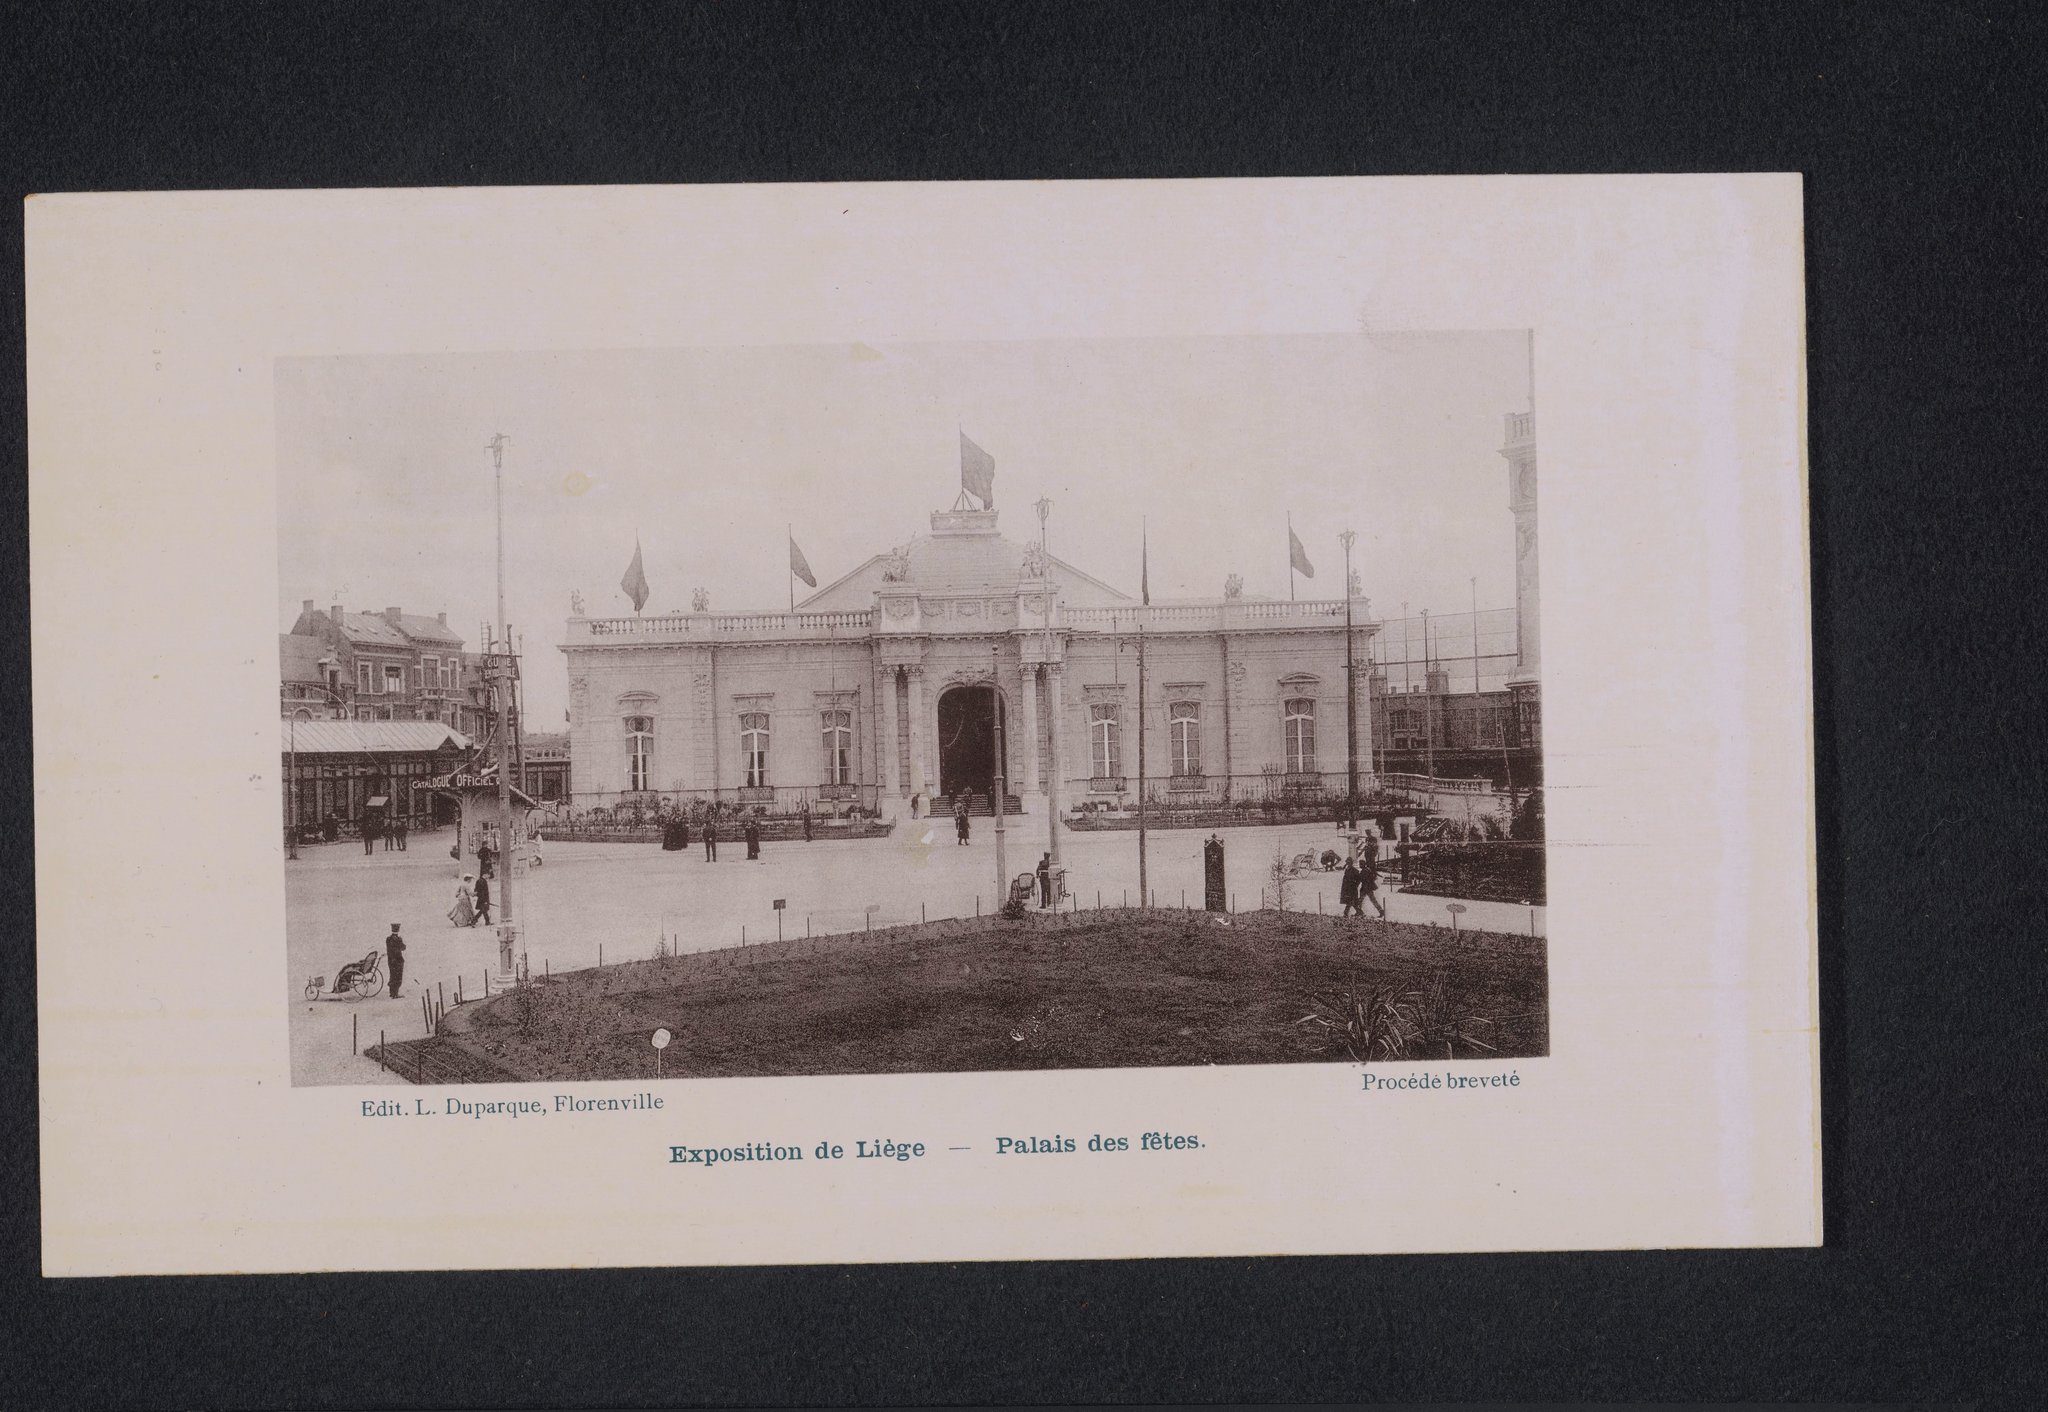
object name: photomechanical print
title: Exposition de Liège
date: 1905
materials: paper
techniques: photograph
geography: liège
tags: musician, world fair, world exhibition, liège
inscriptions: inscription: ‘Procédé breveté’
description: Deze prent maakt deel uit van een omslag met 16 prenten.